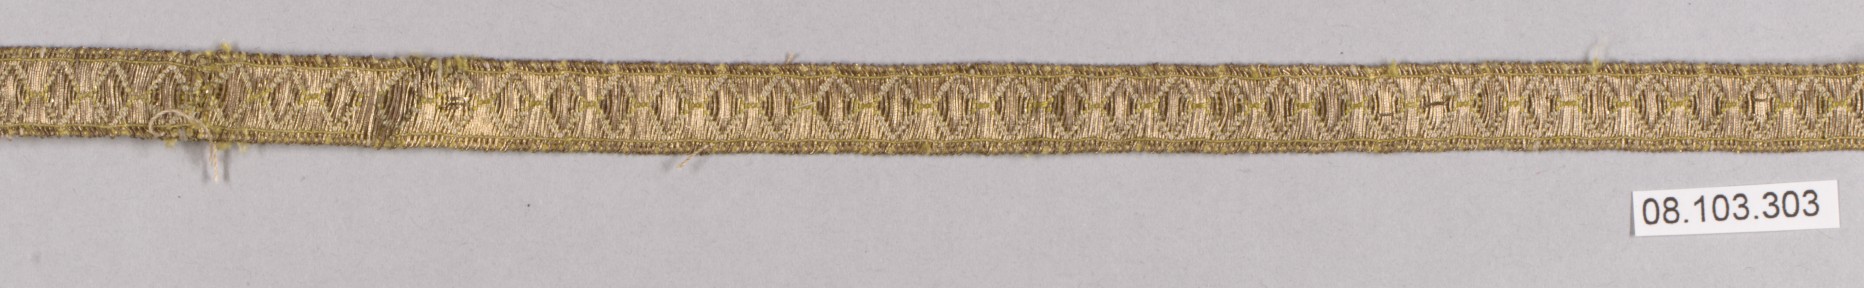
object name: galloon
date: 1601-1800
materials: silk